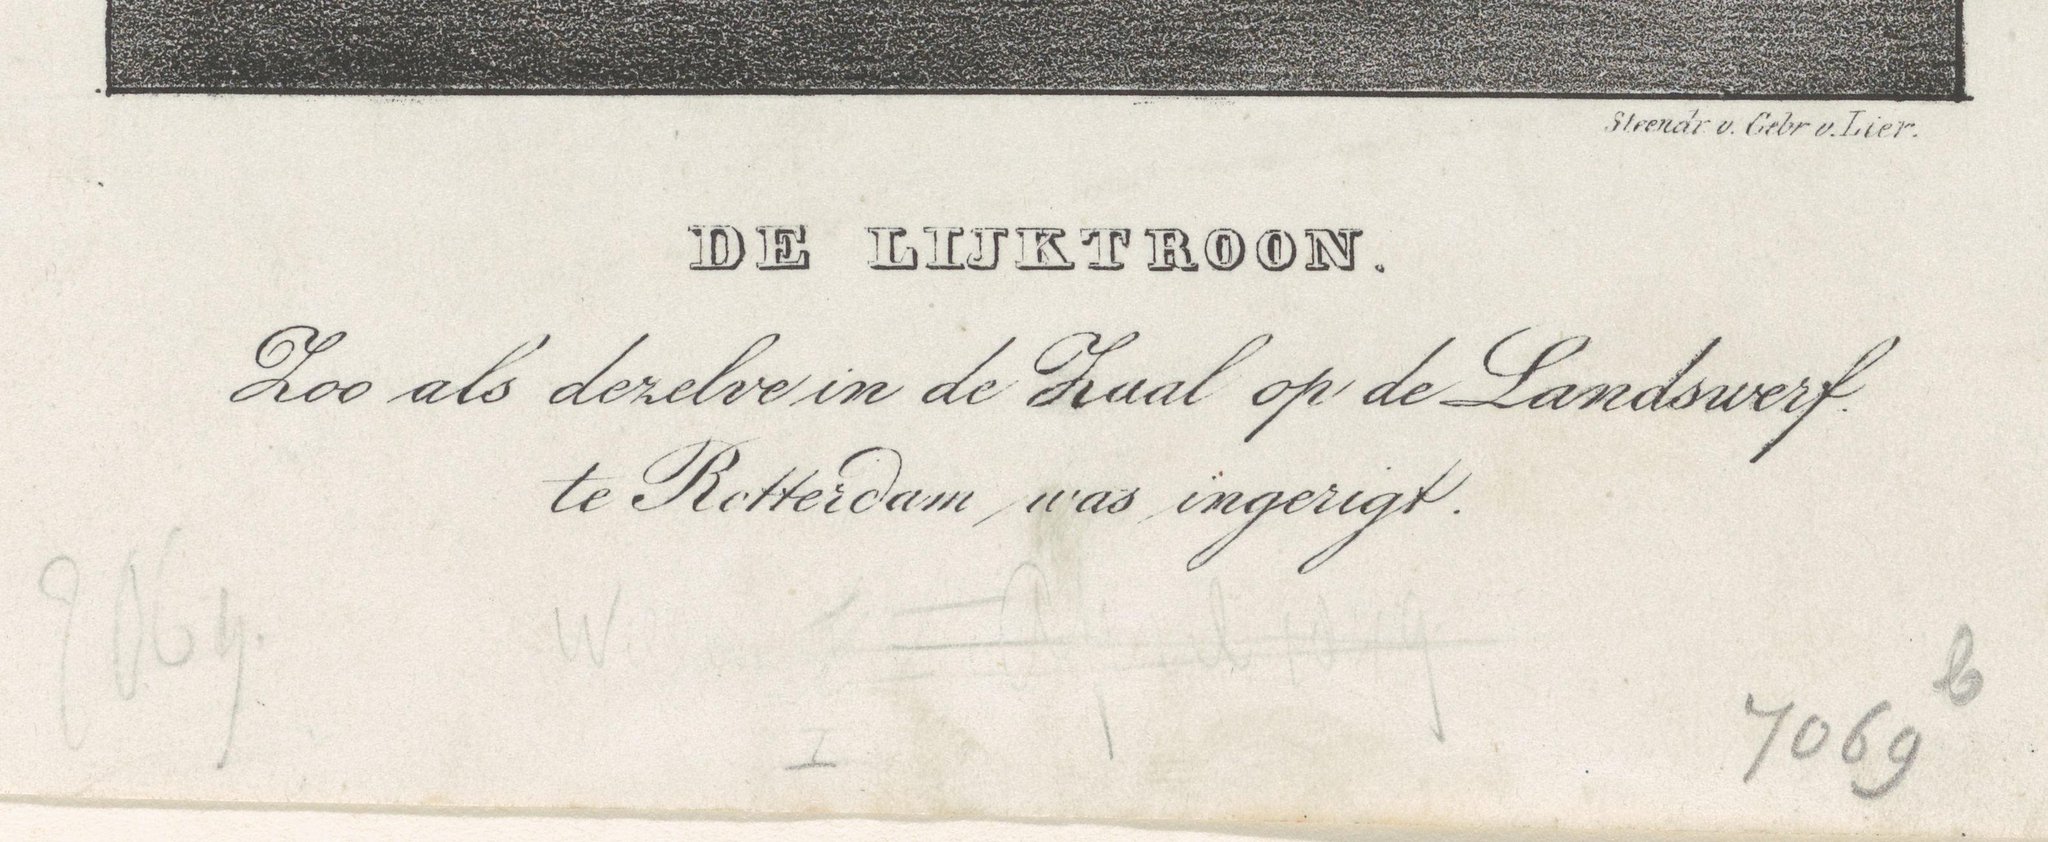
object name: print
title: De Lijktroon. Zoo als derzelve in de Zaal op de Landswerf te Rotterdam was ingerigt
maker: Anonymous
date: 1844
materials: paper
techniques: lithograph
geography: netherlands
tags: berlin, william i of the netherlands, funerary ceremonial, lying in state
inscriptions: collector's mark: Lugt 2228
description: Rouwzaal in de Marinewerf te Rotterdam, met de lijkkist en regalia van de voormalige koning Willem I, overleden op 12 december 1843.